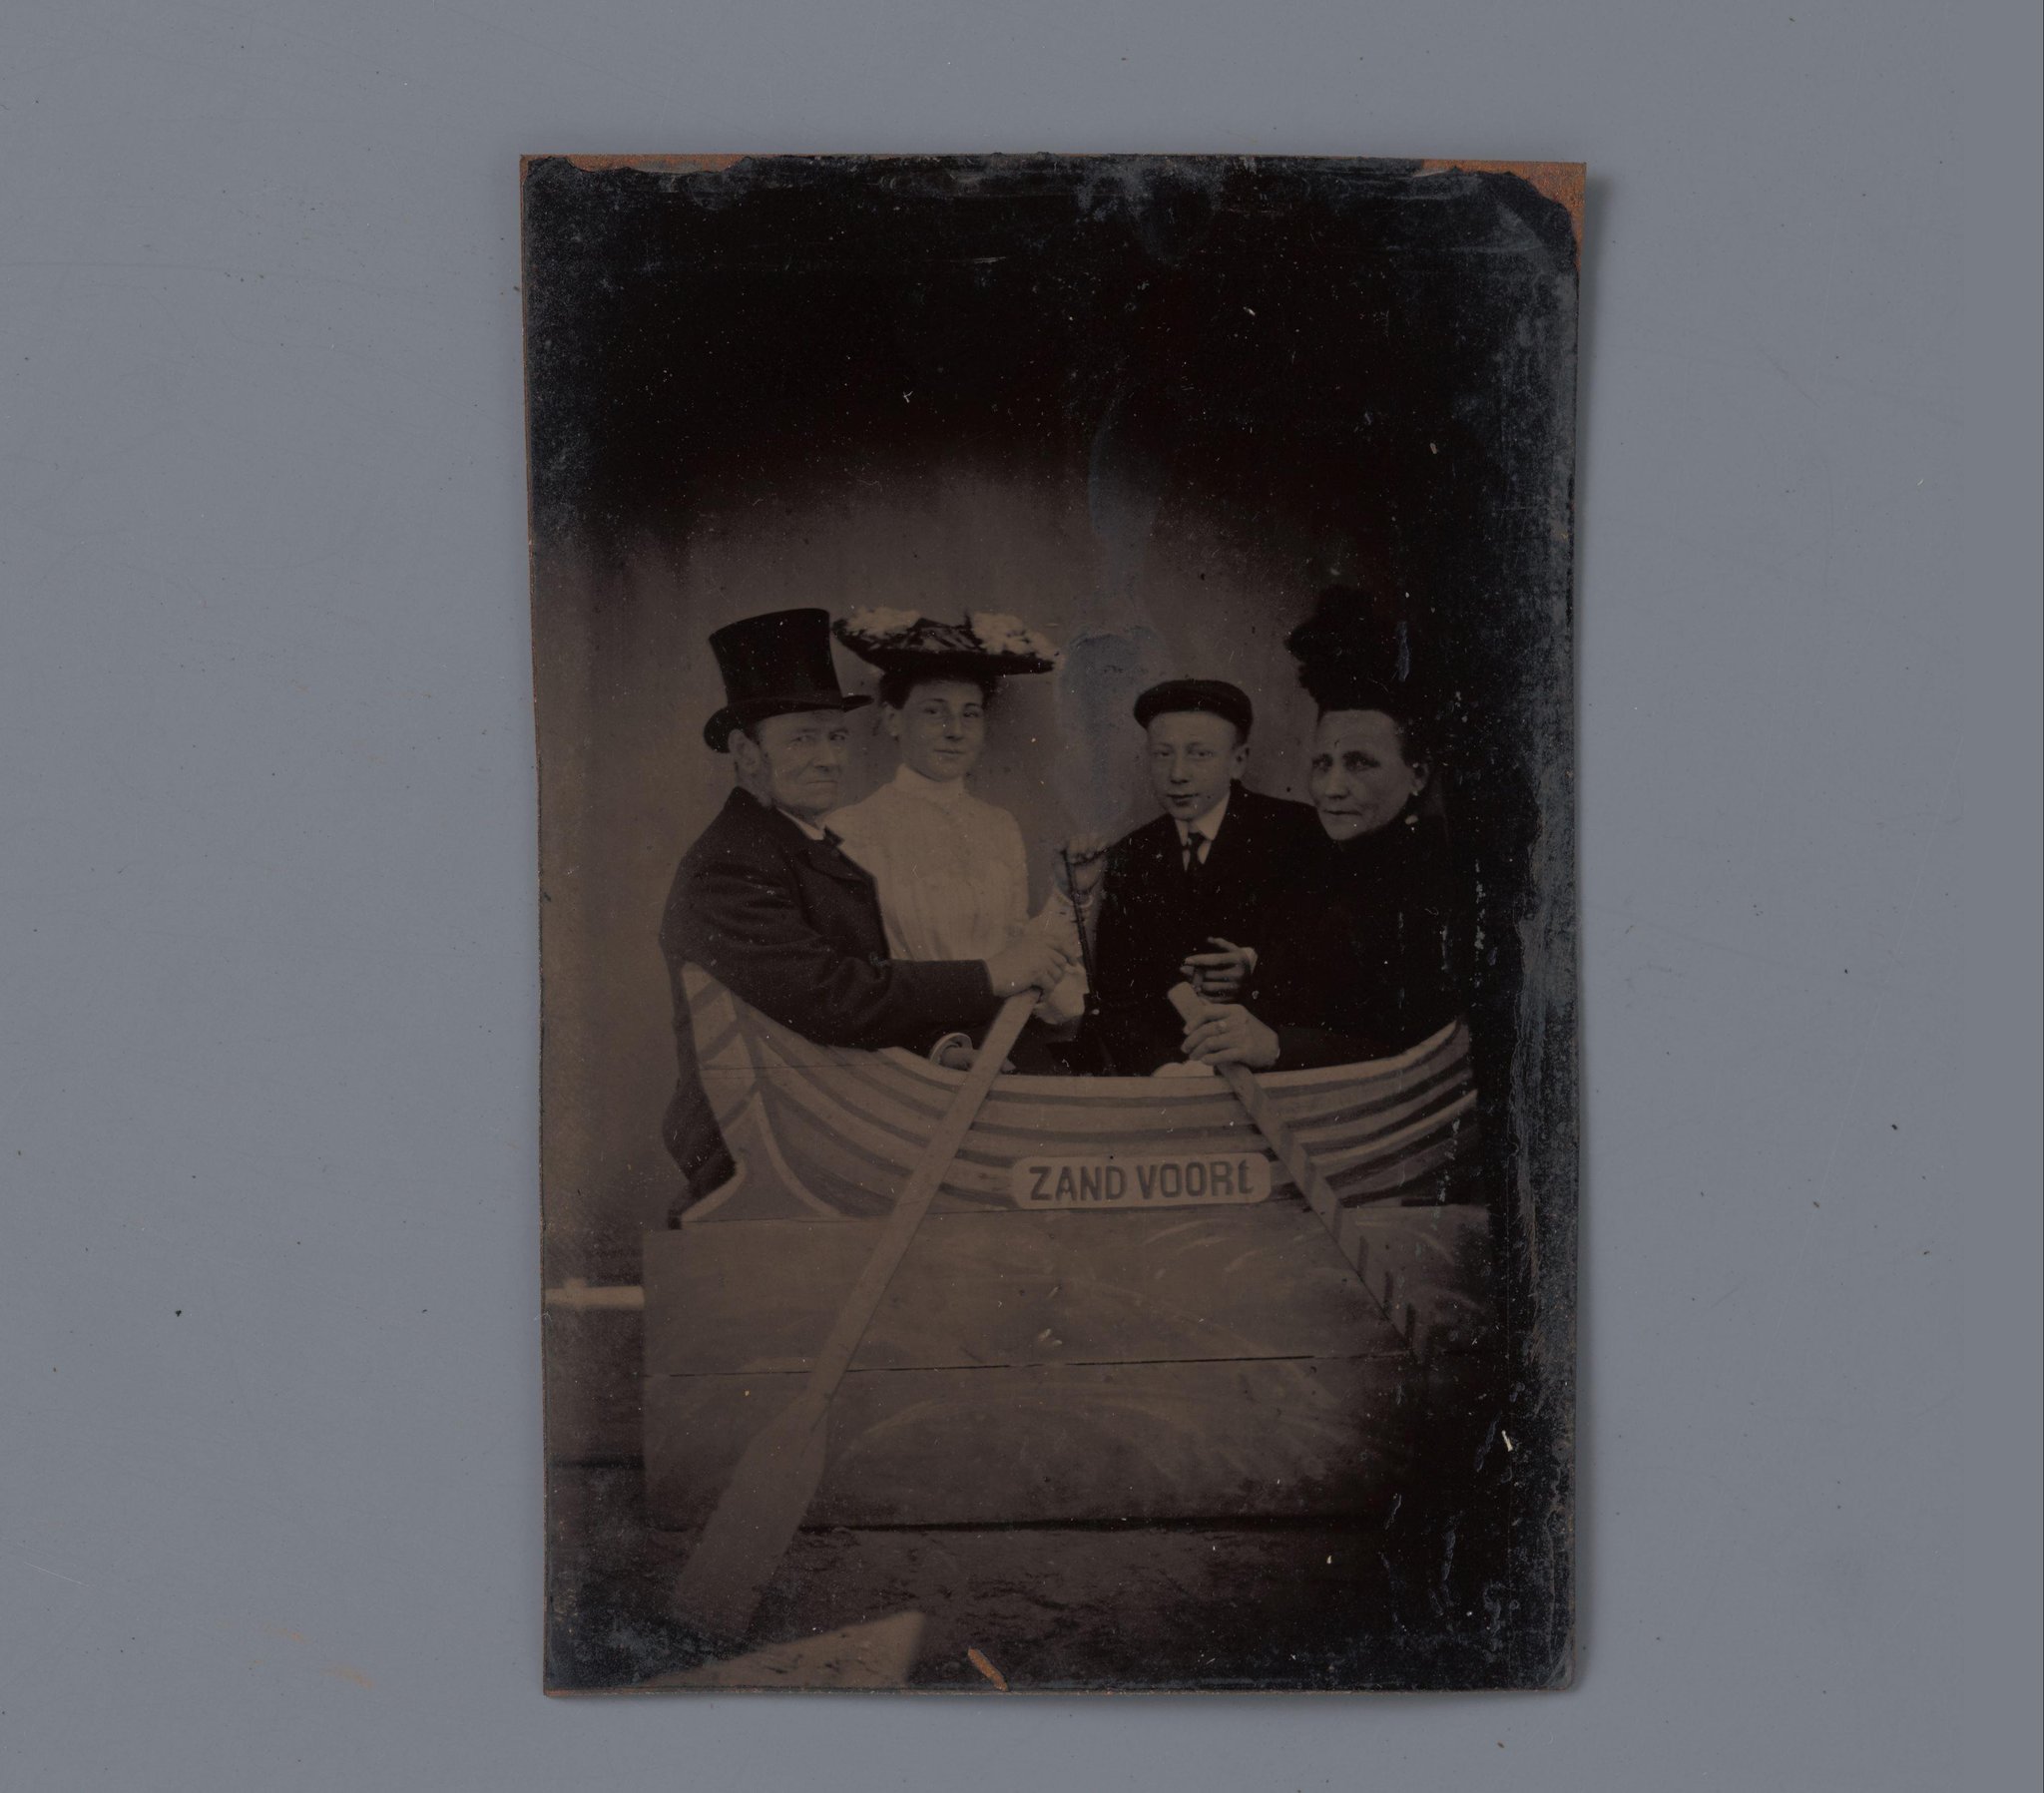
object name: photograph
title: Portret van een onbekend gezin in een roeiboot met de naam Zandvoort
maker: Anonymous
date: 1855-1940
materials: iron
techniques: ferrotyping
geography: zandvoort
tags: rowing-boat, canoe, etc., anonymous historical persons portrayed in a group, in a group-portrait